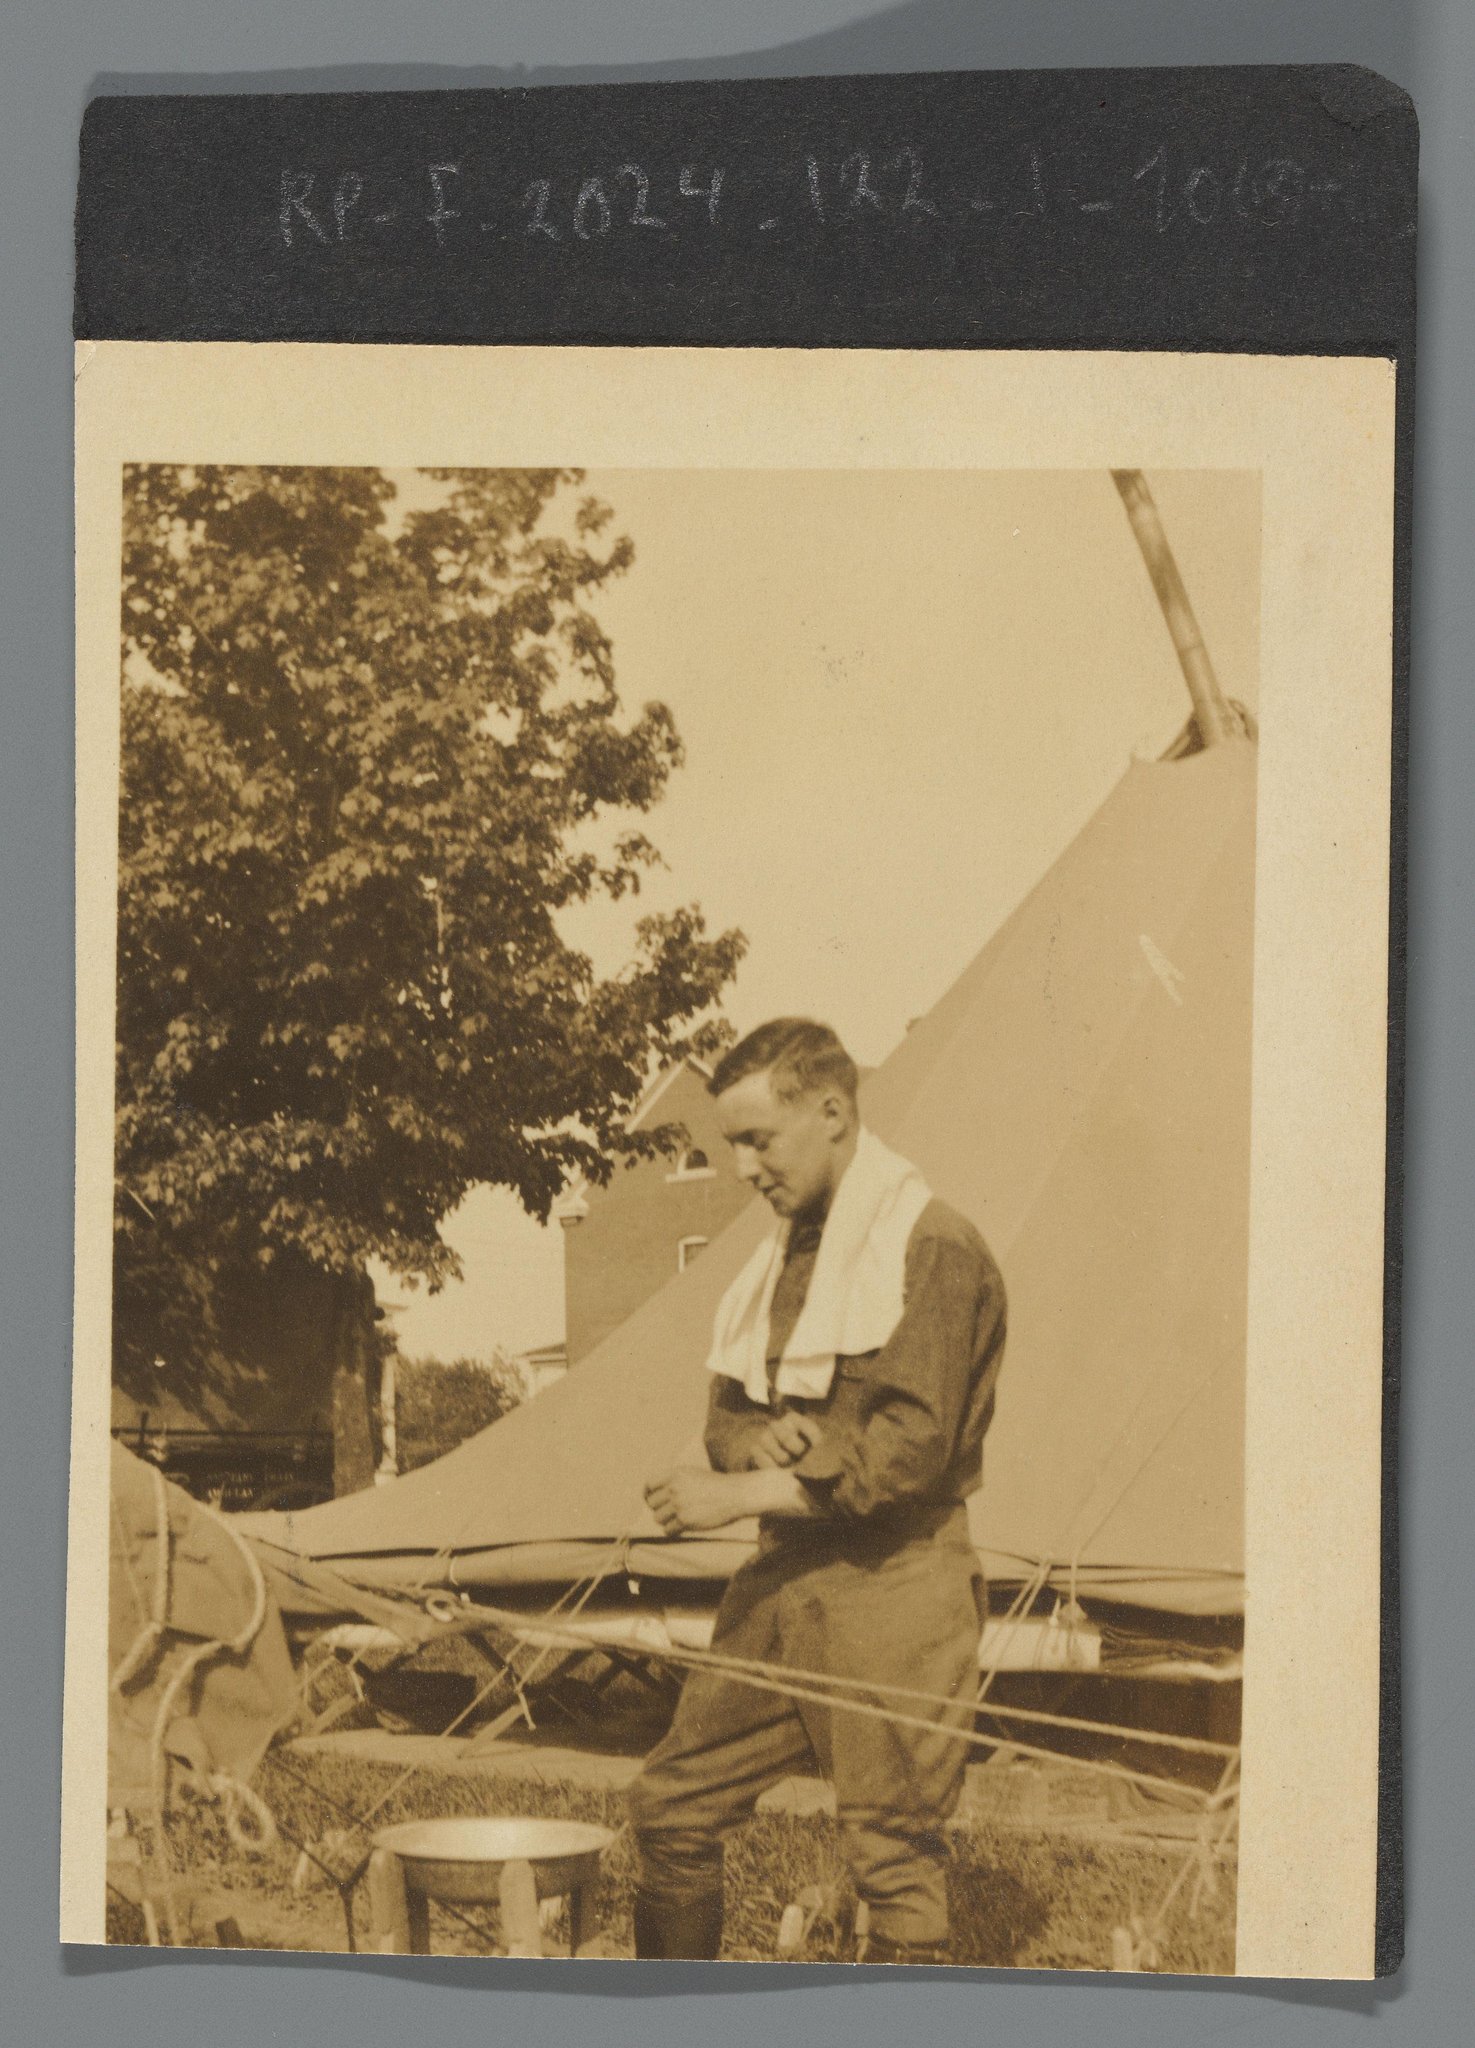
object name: photograph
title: Portret van man voor tent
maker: Anonymous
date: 1915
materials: paper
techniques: gelatin silver print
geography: united states